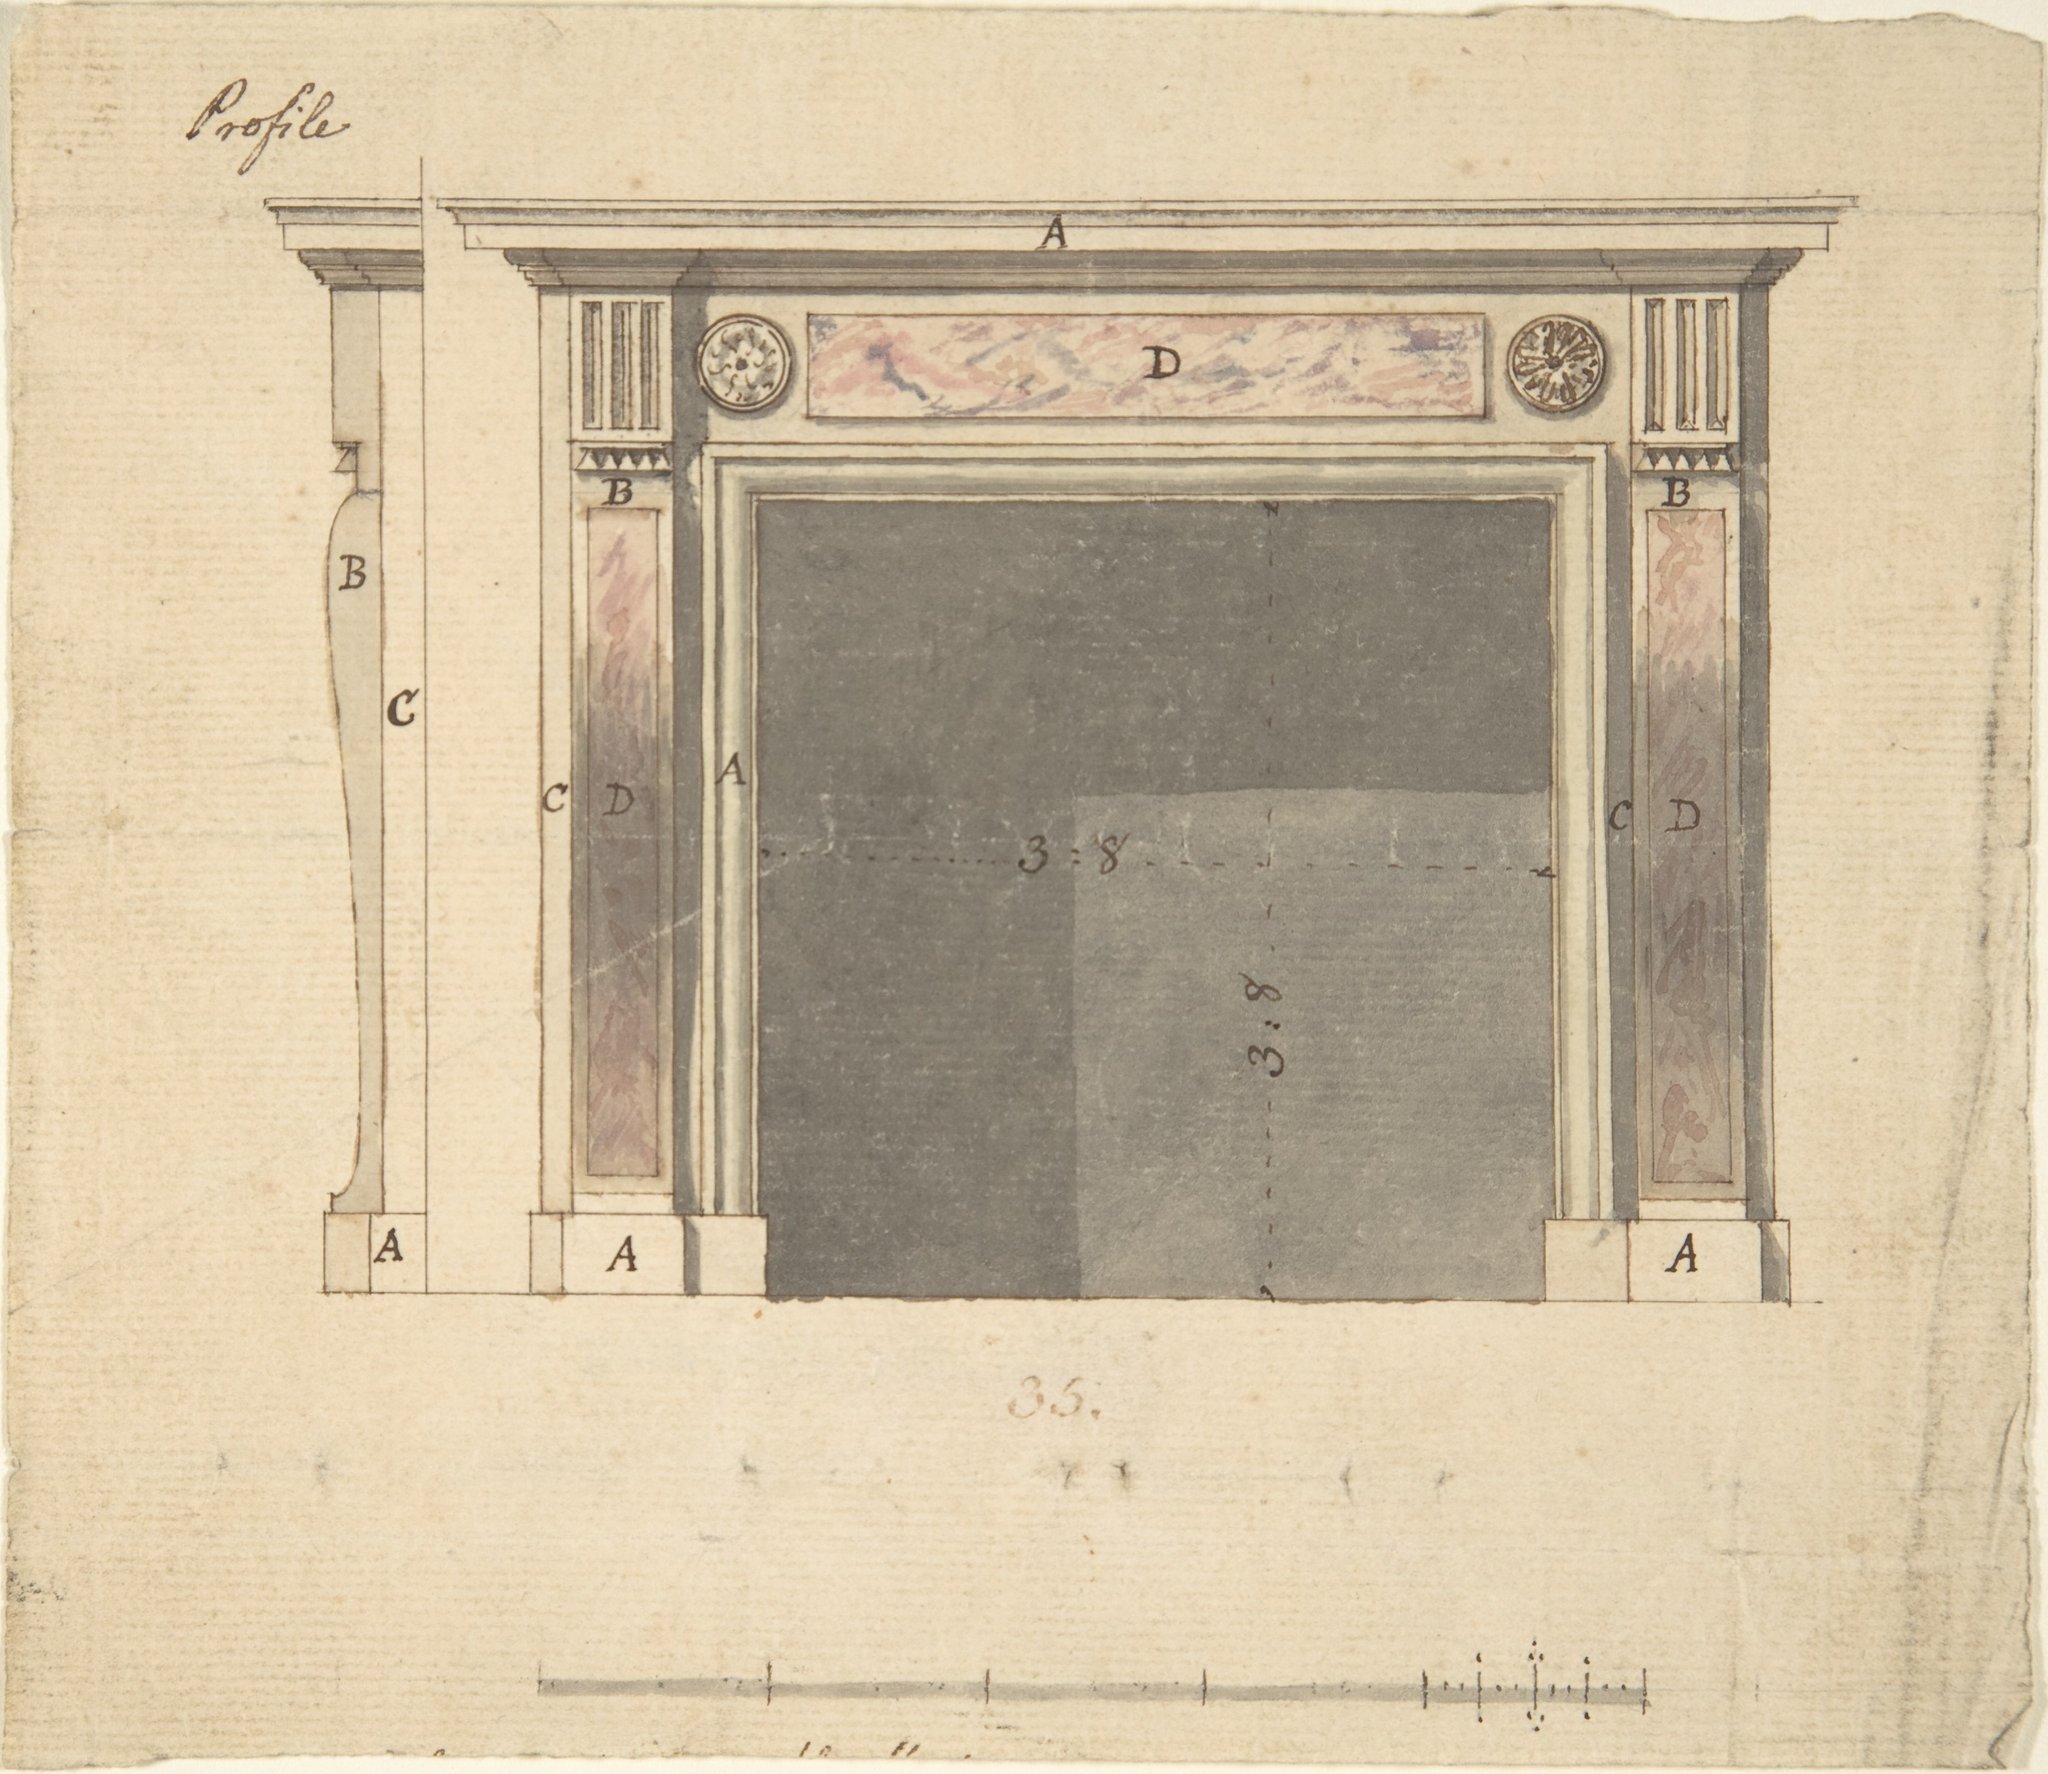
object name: drawing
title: Design for a Chimneypiece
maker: sir william chambers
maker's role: artist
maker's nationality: british, born sweden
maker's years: 1723-1796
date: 1740-1800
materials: ink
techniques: brush, pen, wash